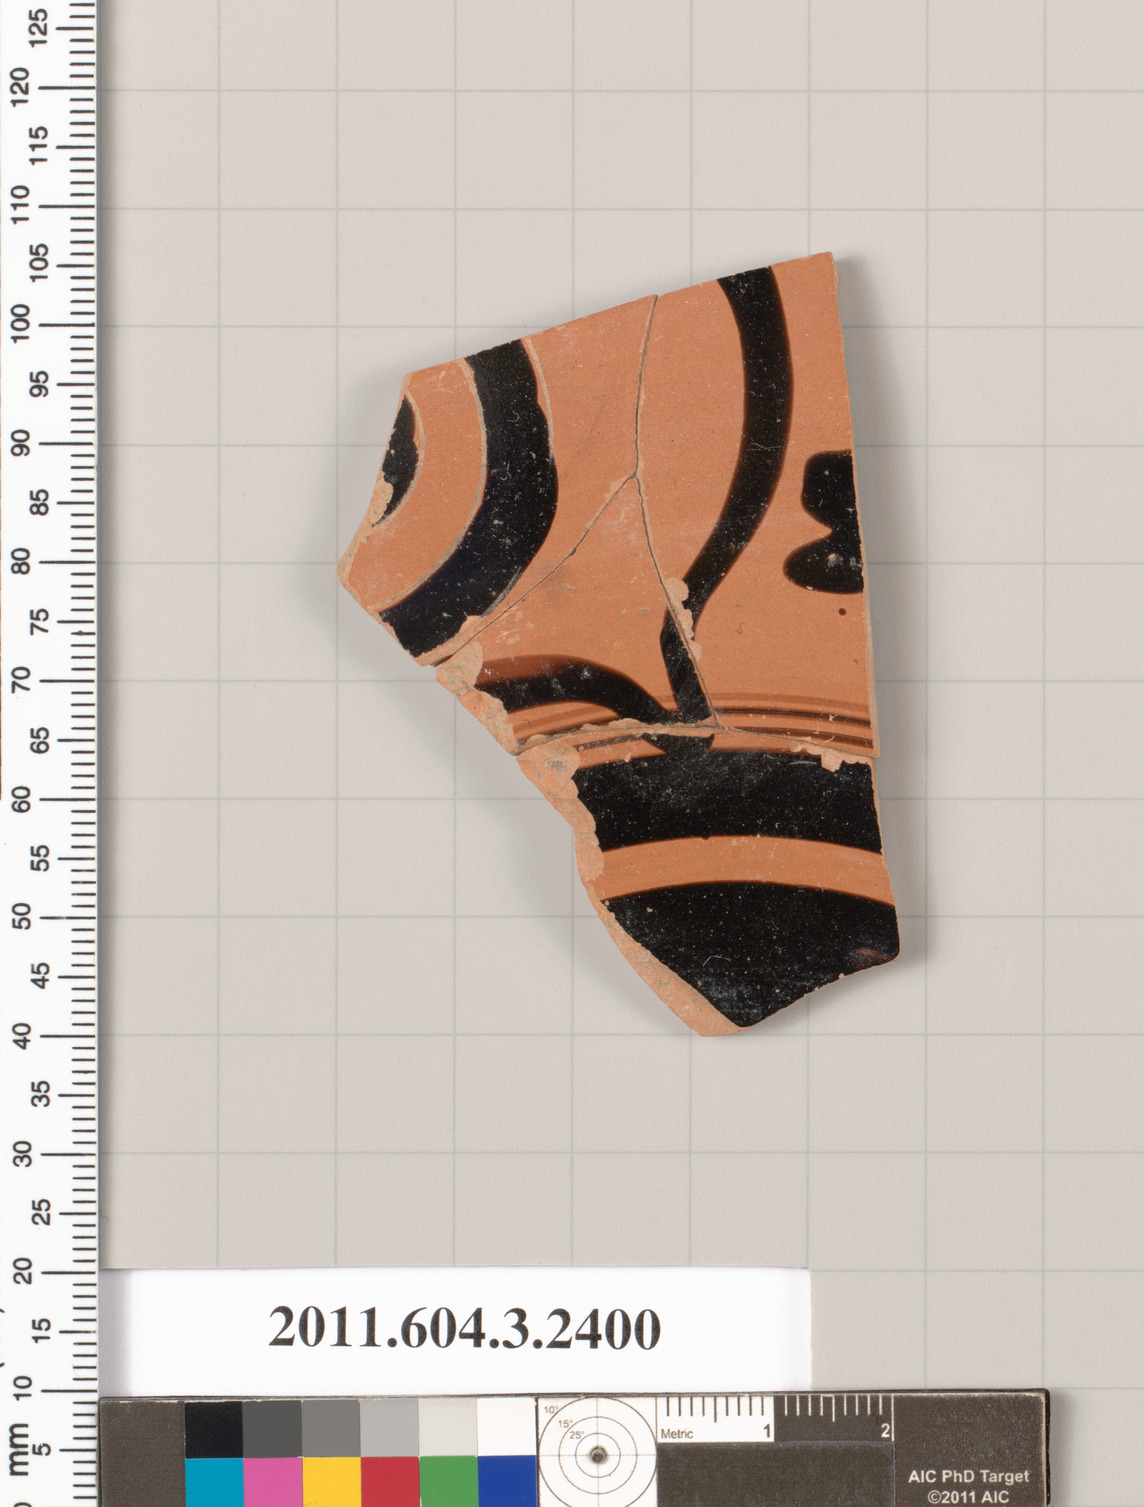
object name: kylix fragment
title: Terracotta fragment of a kylix: eye-cup (drinking cup)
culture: greek, attic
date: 530-510 BCE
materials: terracotta